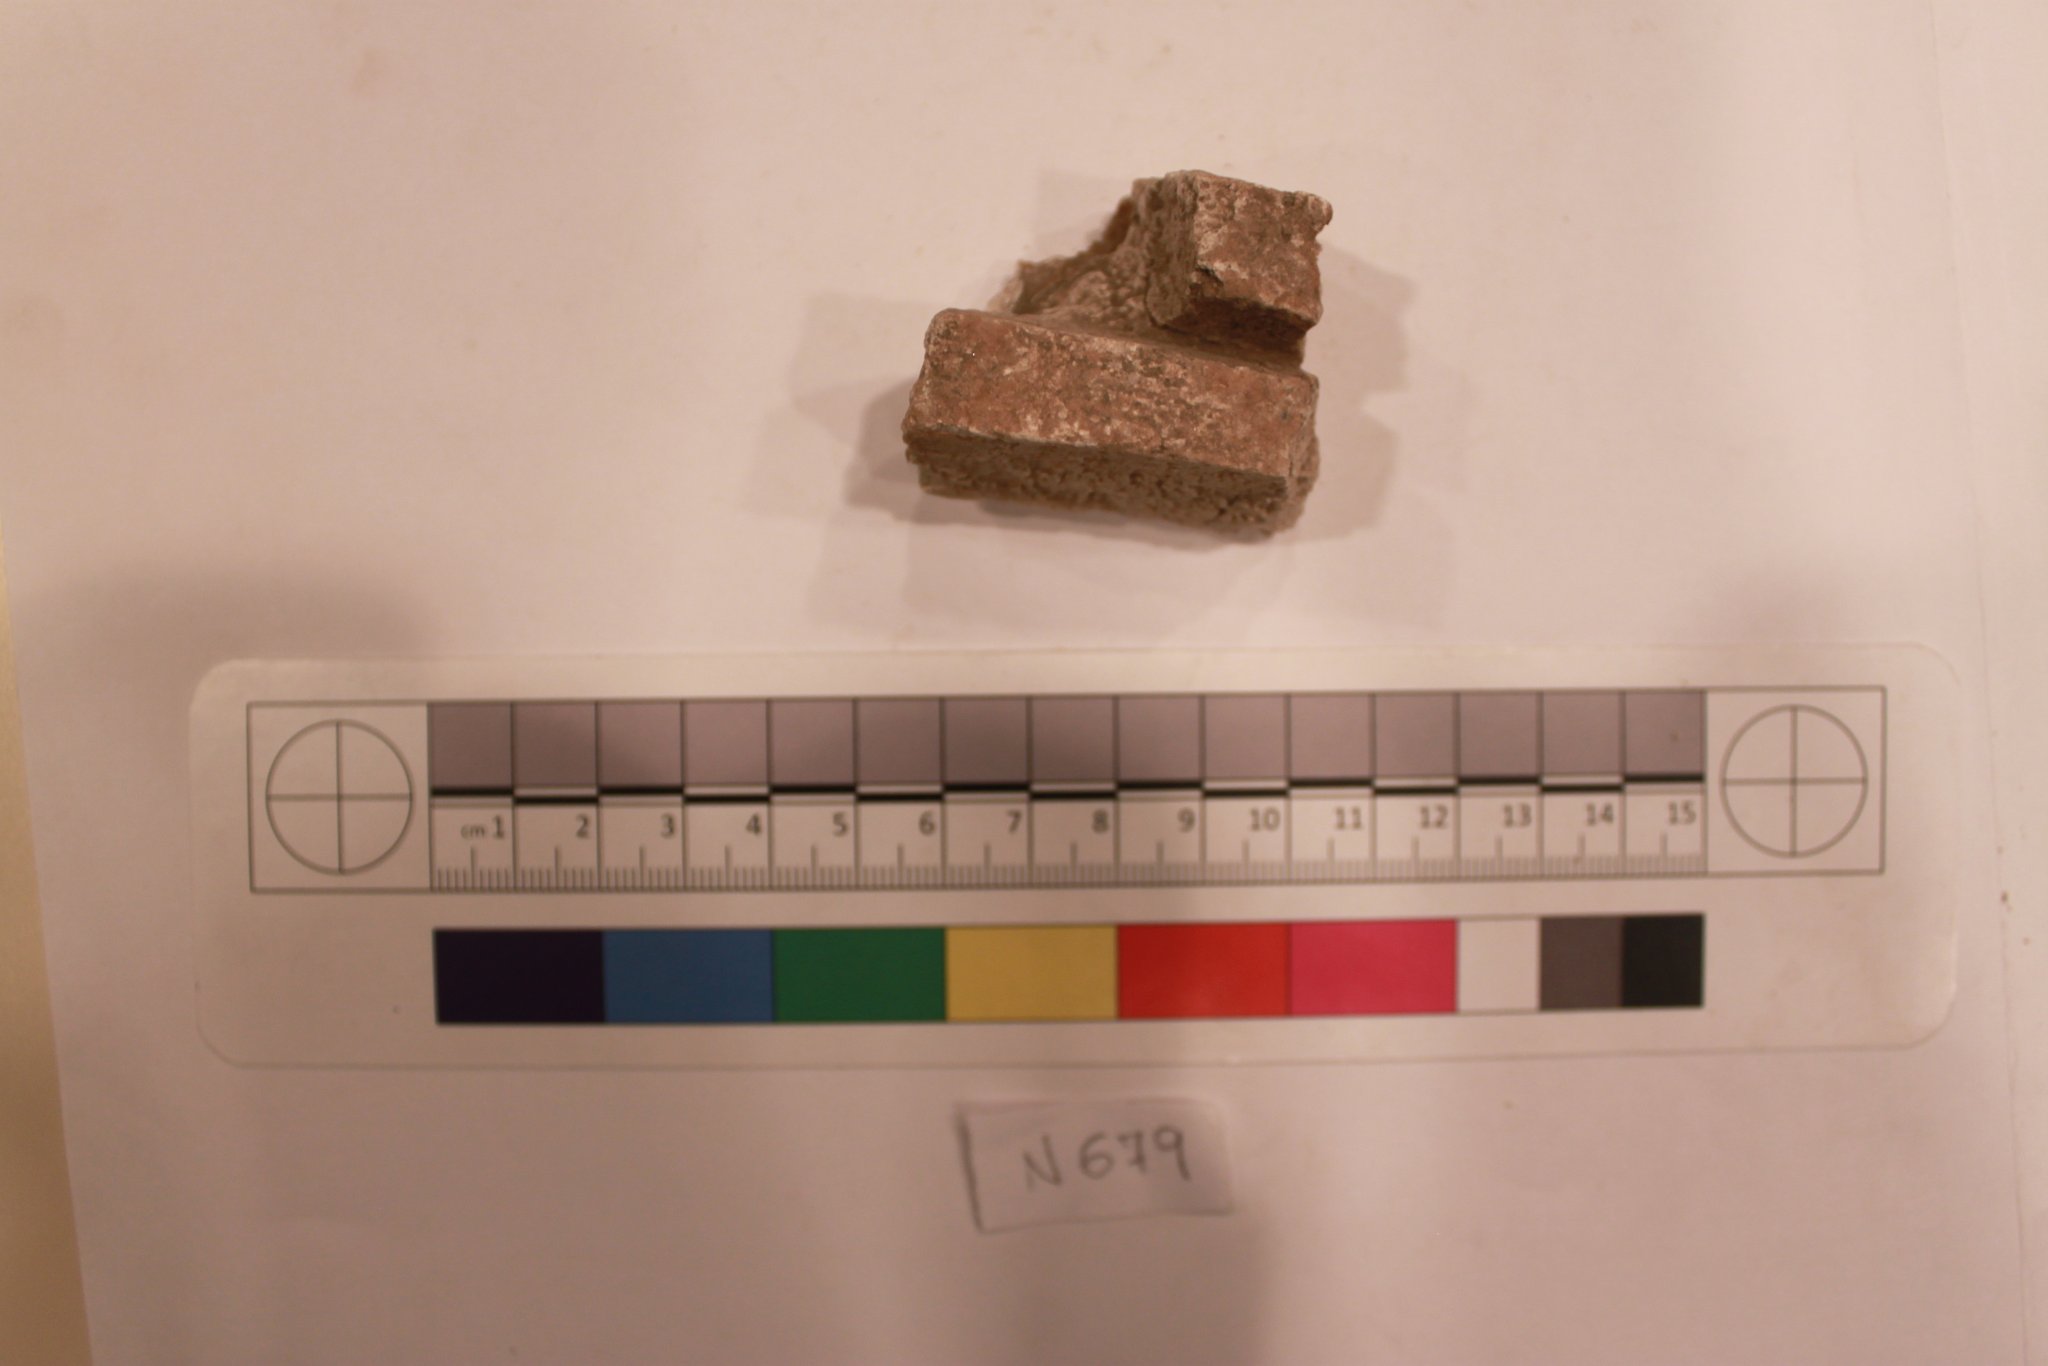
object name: fragment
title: Stucco Fragment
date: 701-1200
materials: plaster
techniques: carving, painting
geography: iran